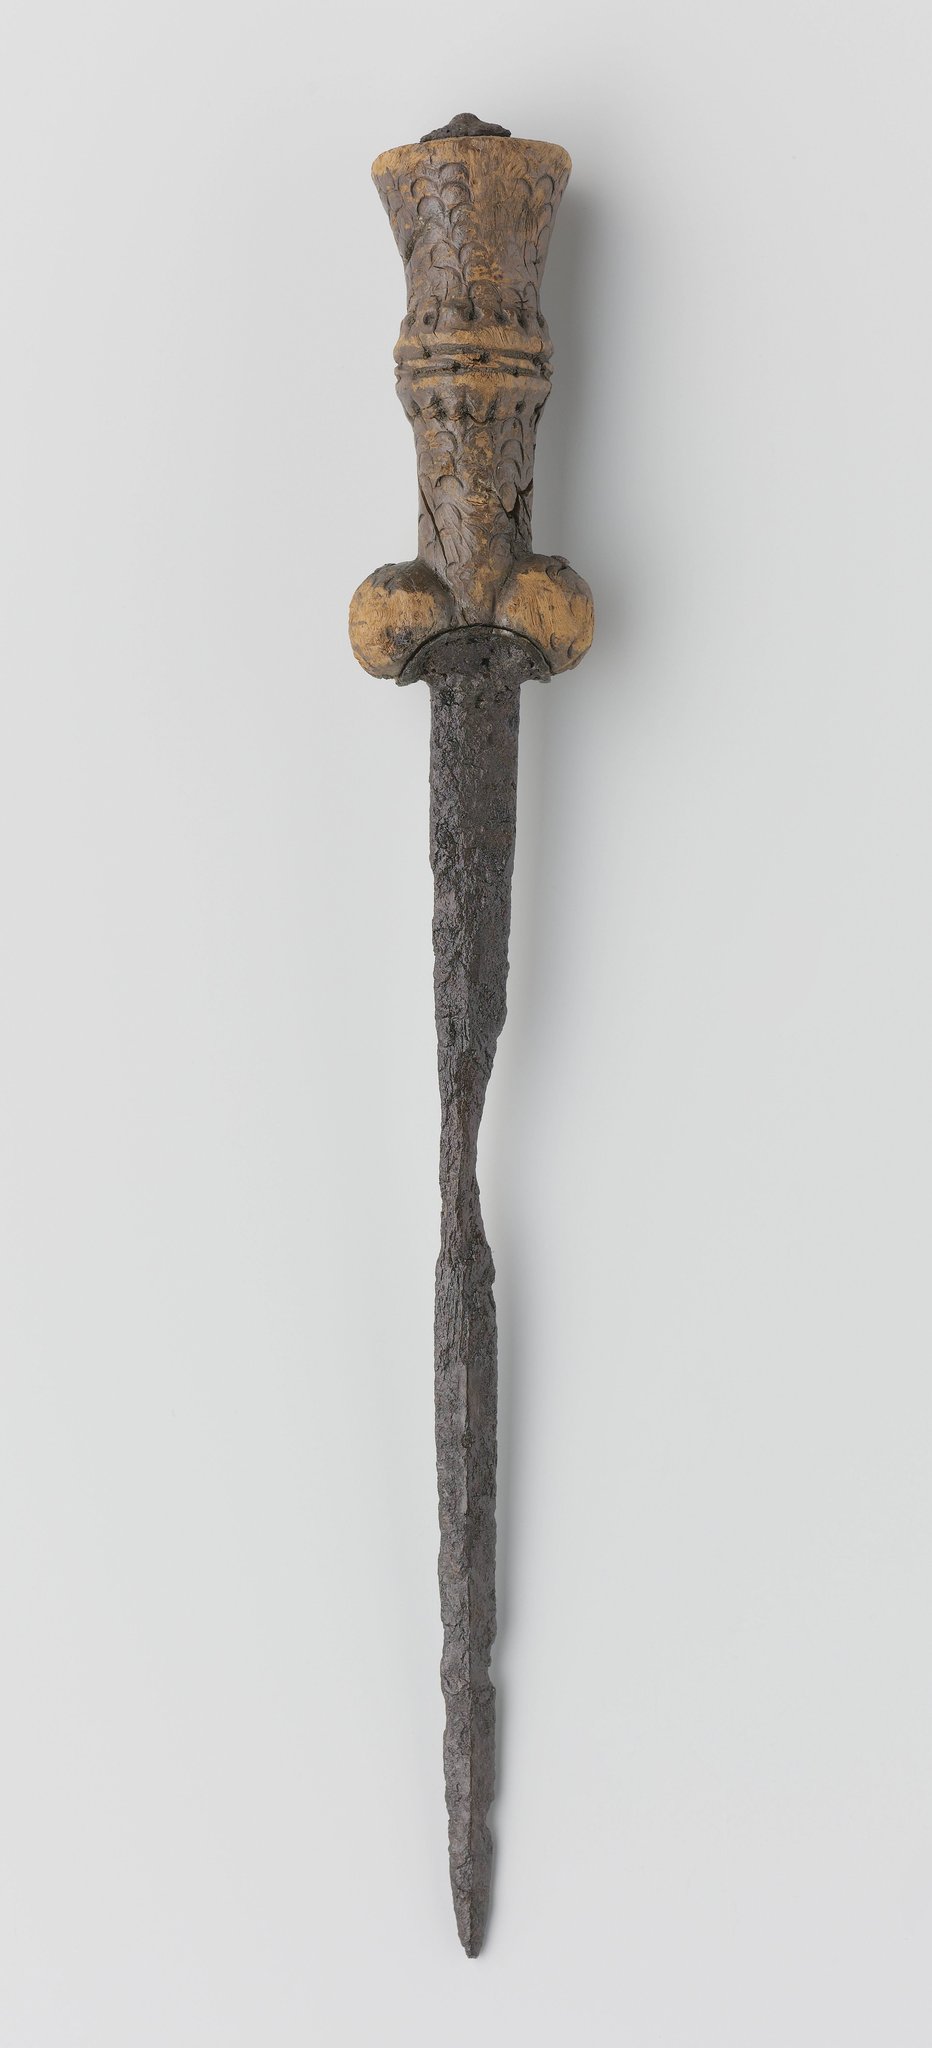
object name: dagger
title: Two daggers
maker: Anonymous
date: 1475-1524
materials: brass, copper, wood, iron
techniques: cutting, forging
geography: low countries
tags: low countries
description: Soldiers used daggers mainly in hand-to-hand combat, but these thrusting weapons were also a status symbol for the nobility. Various types were in use, often with an embellished hilt. A dagger with two lobes at the guard was called a ‘bollock dagger’ or a ‘kidney dagger’. These two daggers were found buried, which is why the blades are damaged.